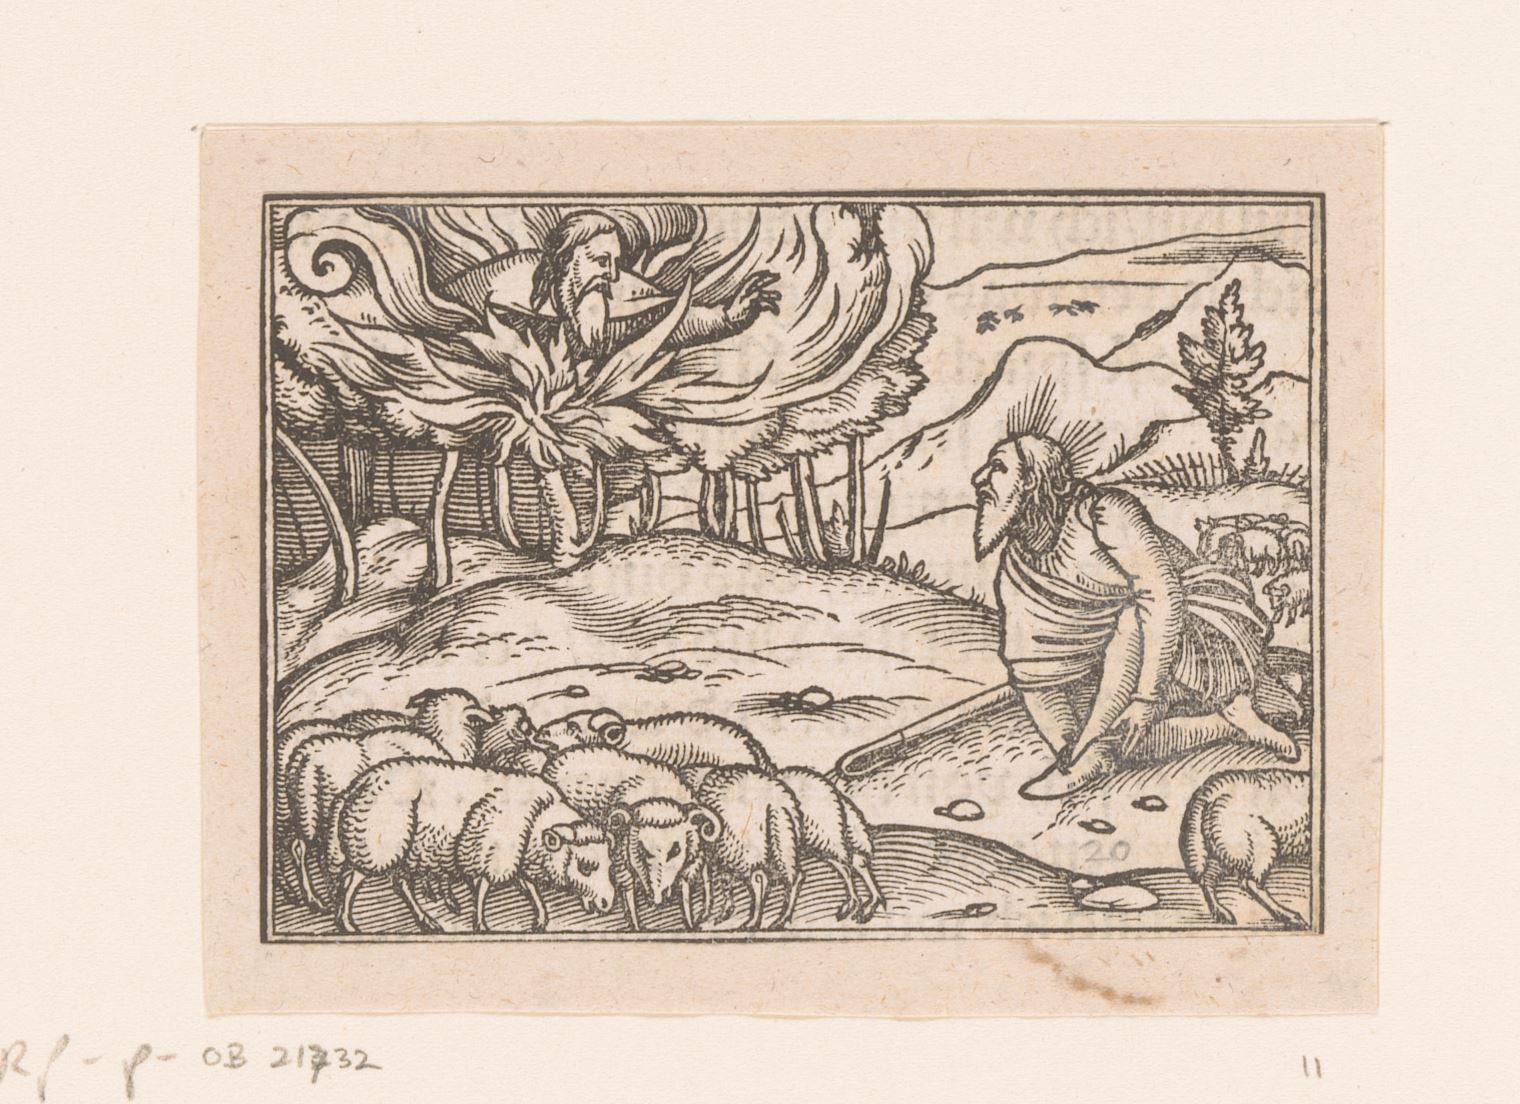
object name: print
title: Mozes en de brandende braamstruik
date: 1552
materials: paper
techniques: woodcut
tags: the burning bush ~ calling of moses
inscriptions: collector's mark: Lugt 240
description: Kopie van een houtsnede van Hans Holbein de jongere uit 1526. Origineel voor het eerst als boekillustratie gebruikt in: Biblia Utriusque Testamenti iuxta Vulgatam Translationem, Lyon, M. en G. Trechsel (voor Hugo à Porta) 1538. Deze kopie gemaakt voor: Biblia sacra iuxta vulgatam. Parijs: Jean Benoît, 1552.